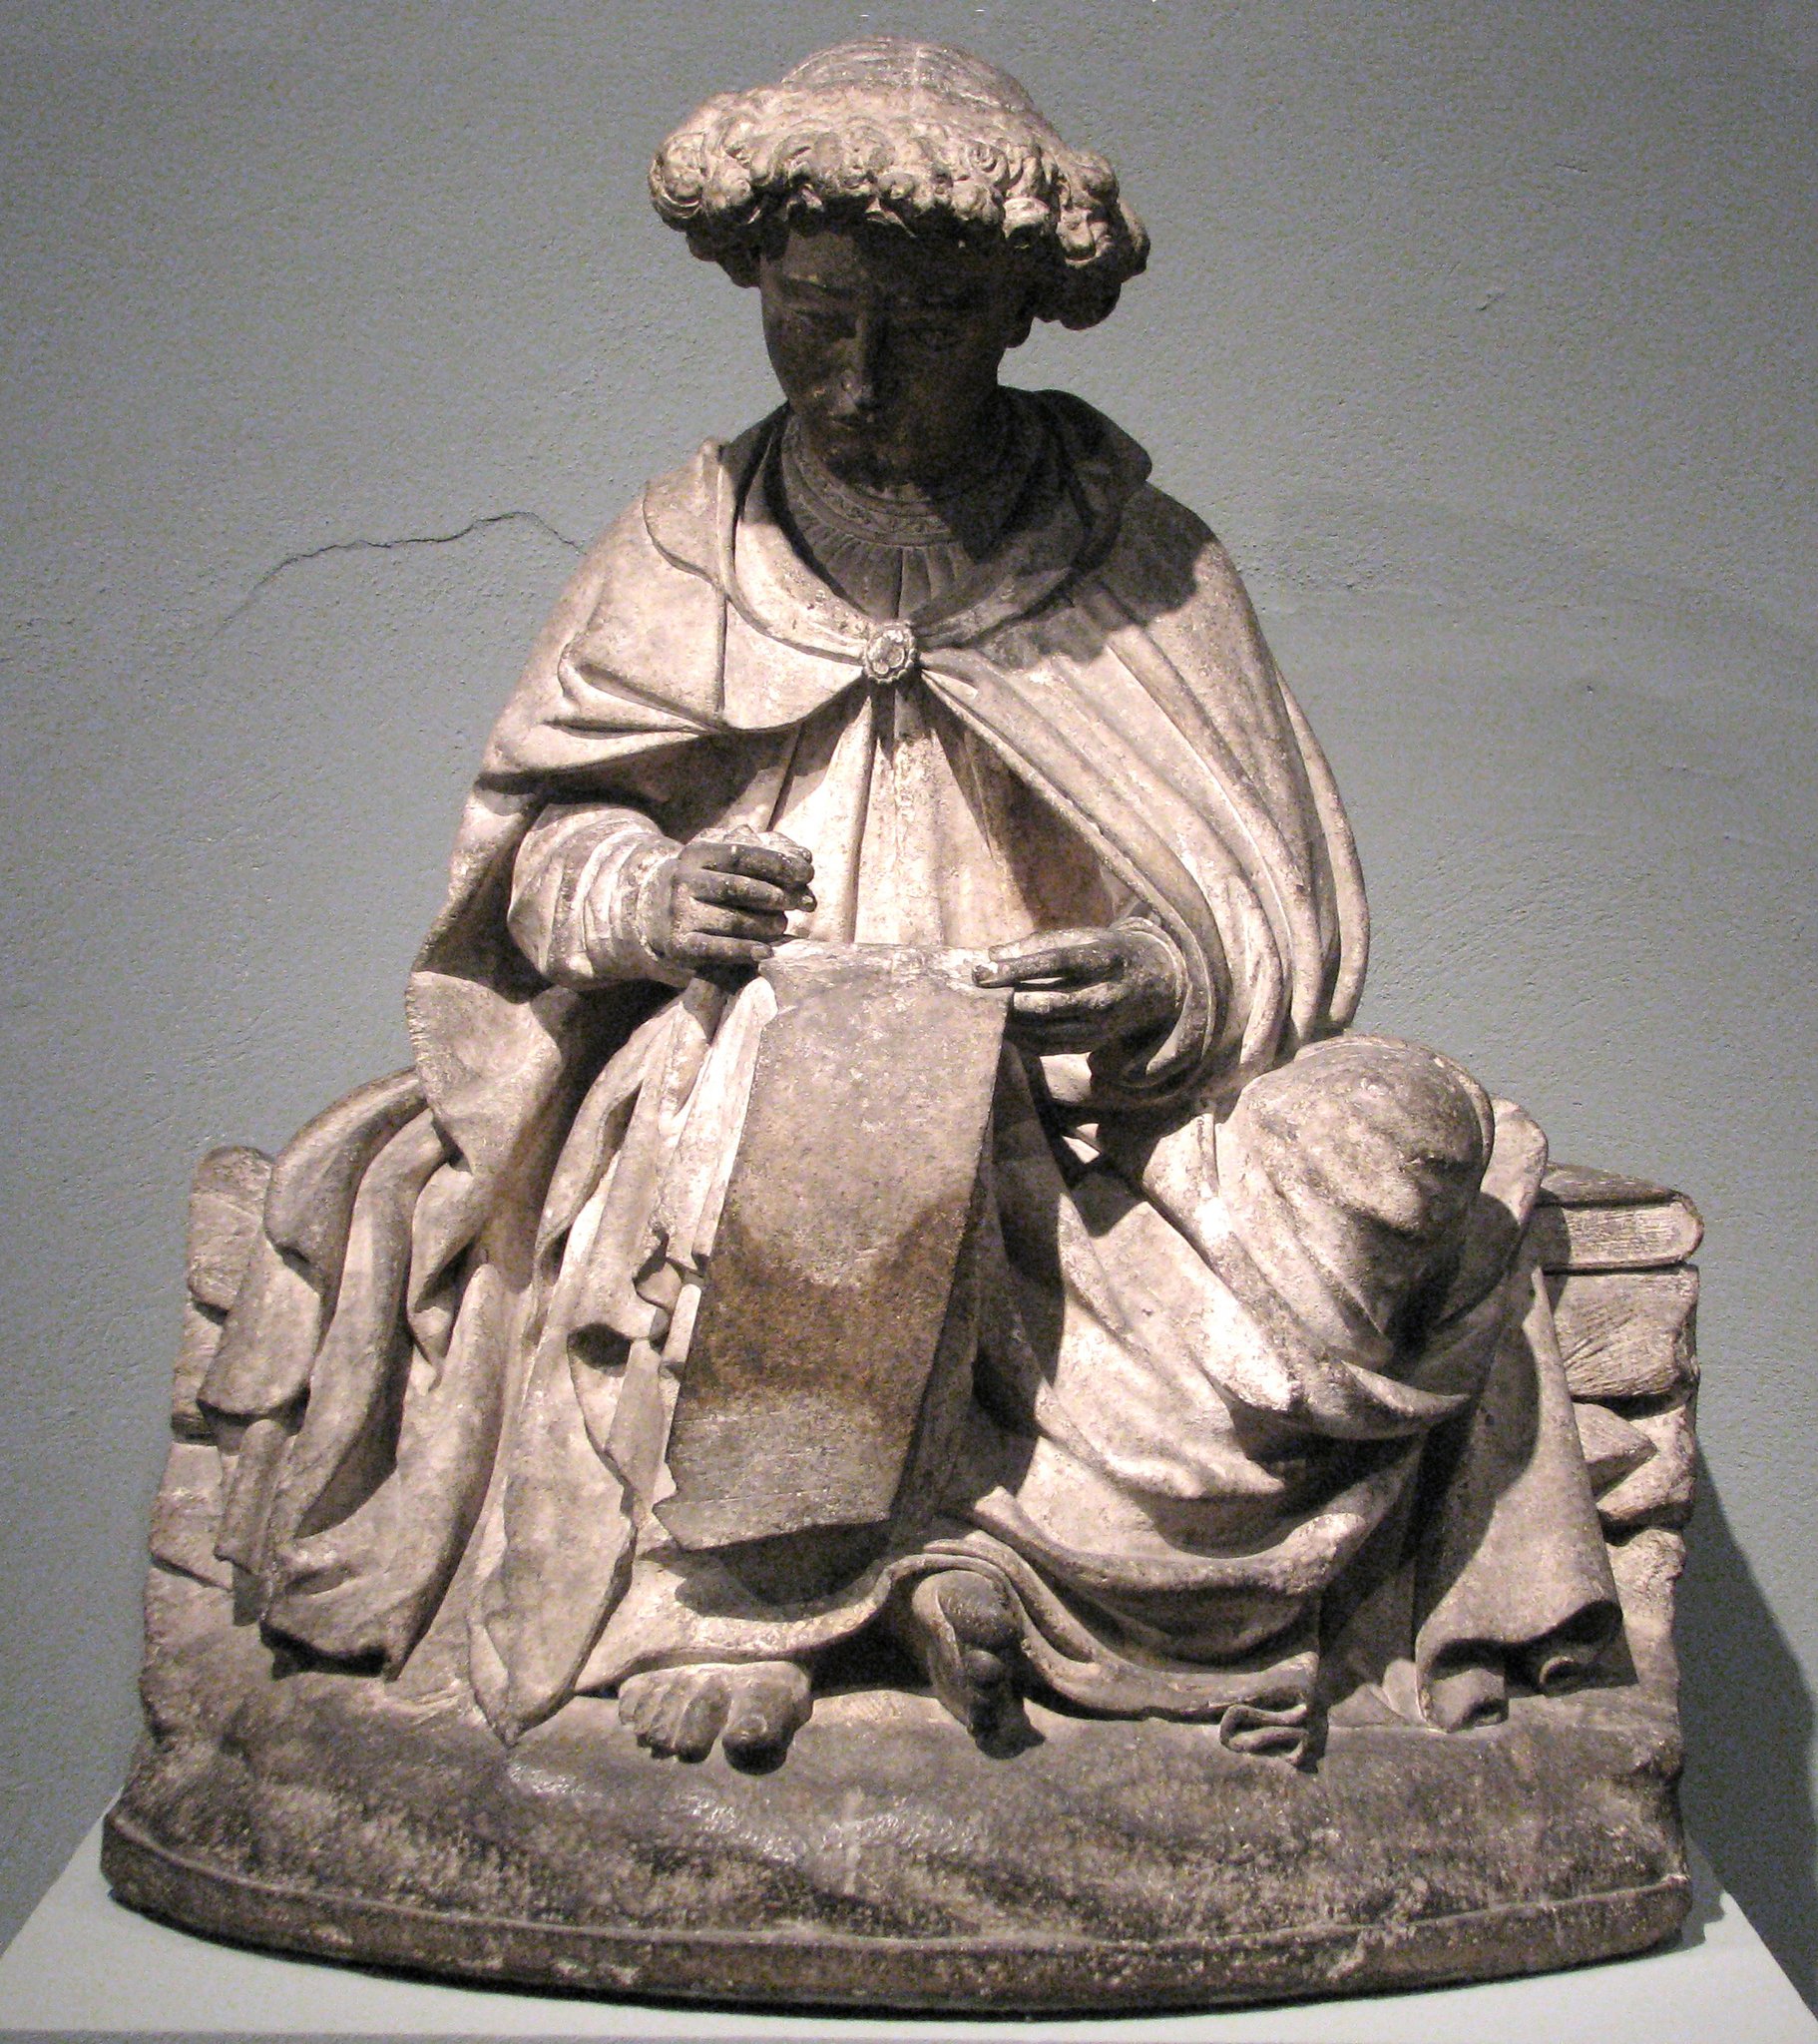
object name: statue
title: Saint John on Patmos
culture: french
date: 1450-1500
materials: limestone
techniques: polychrome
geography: france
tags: saint john the evangelist,writing